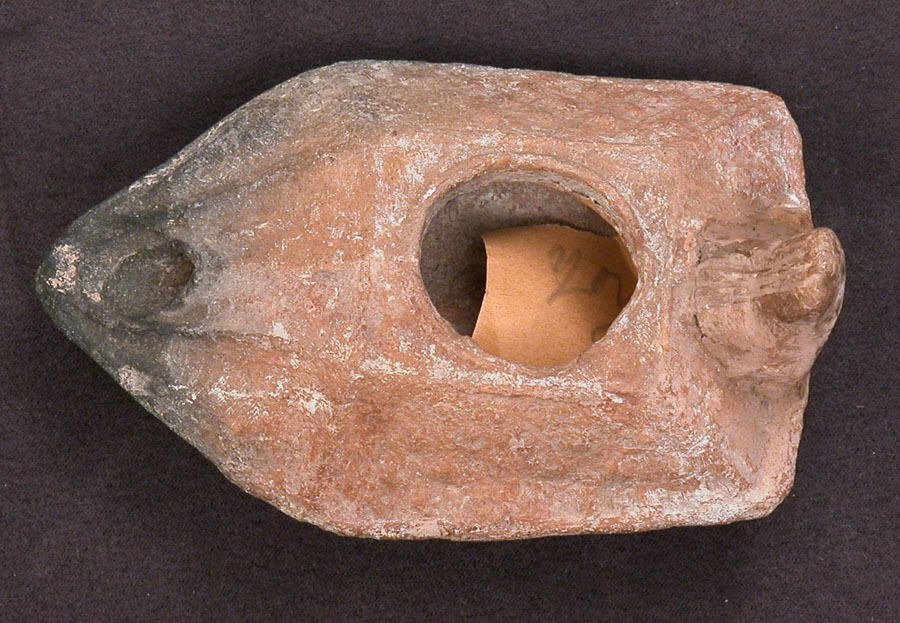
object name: lamp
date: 601-1100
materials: earthenware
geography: palestine